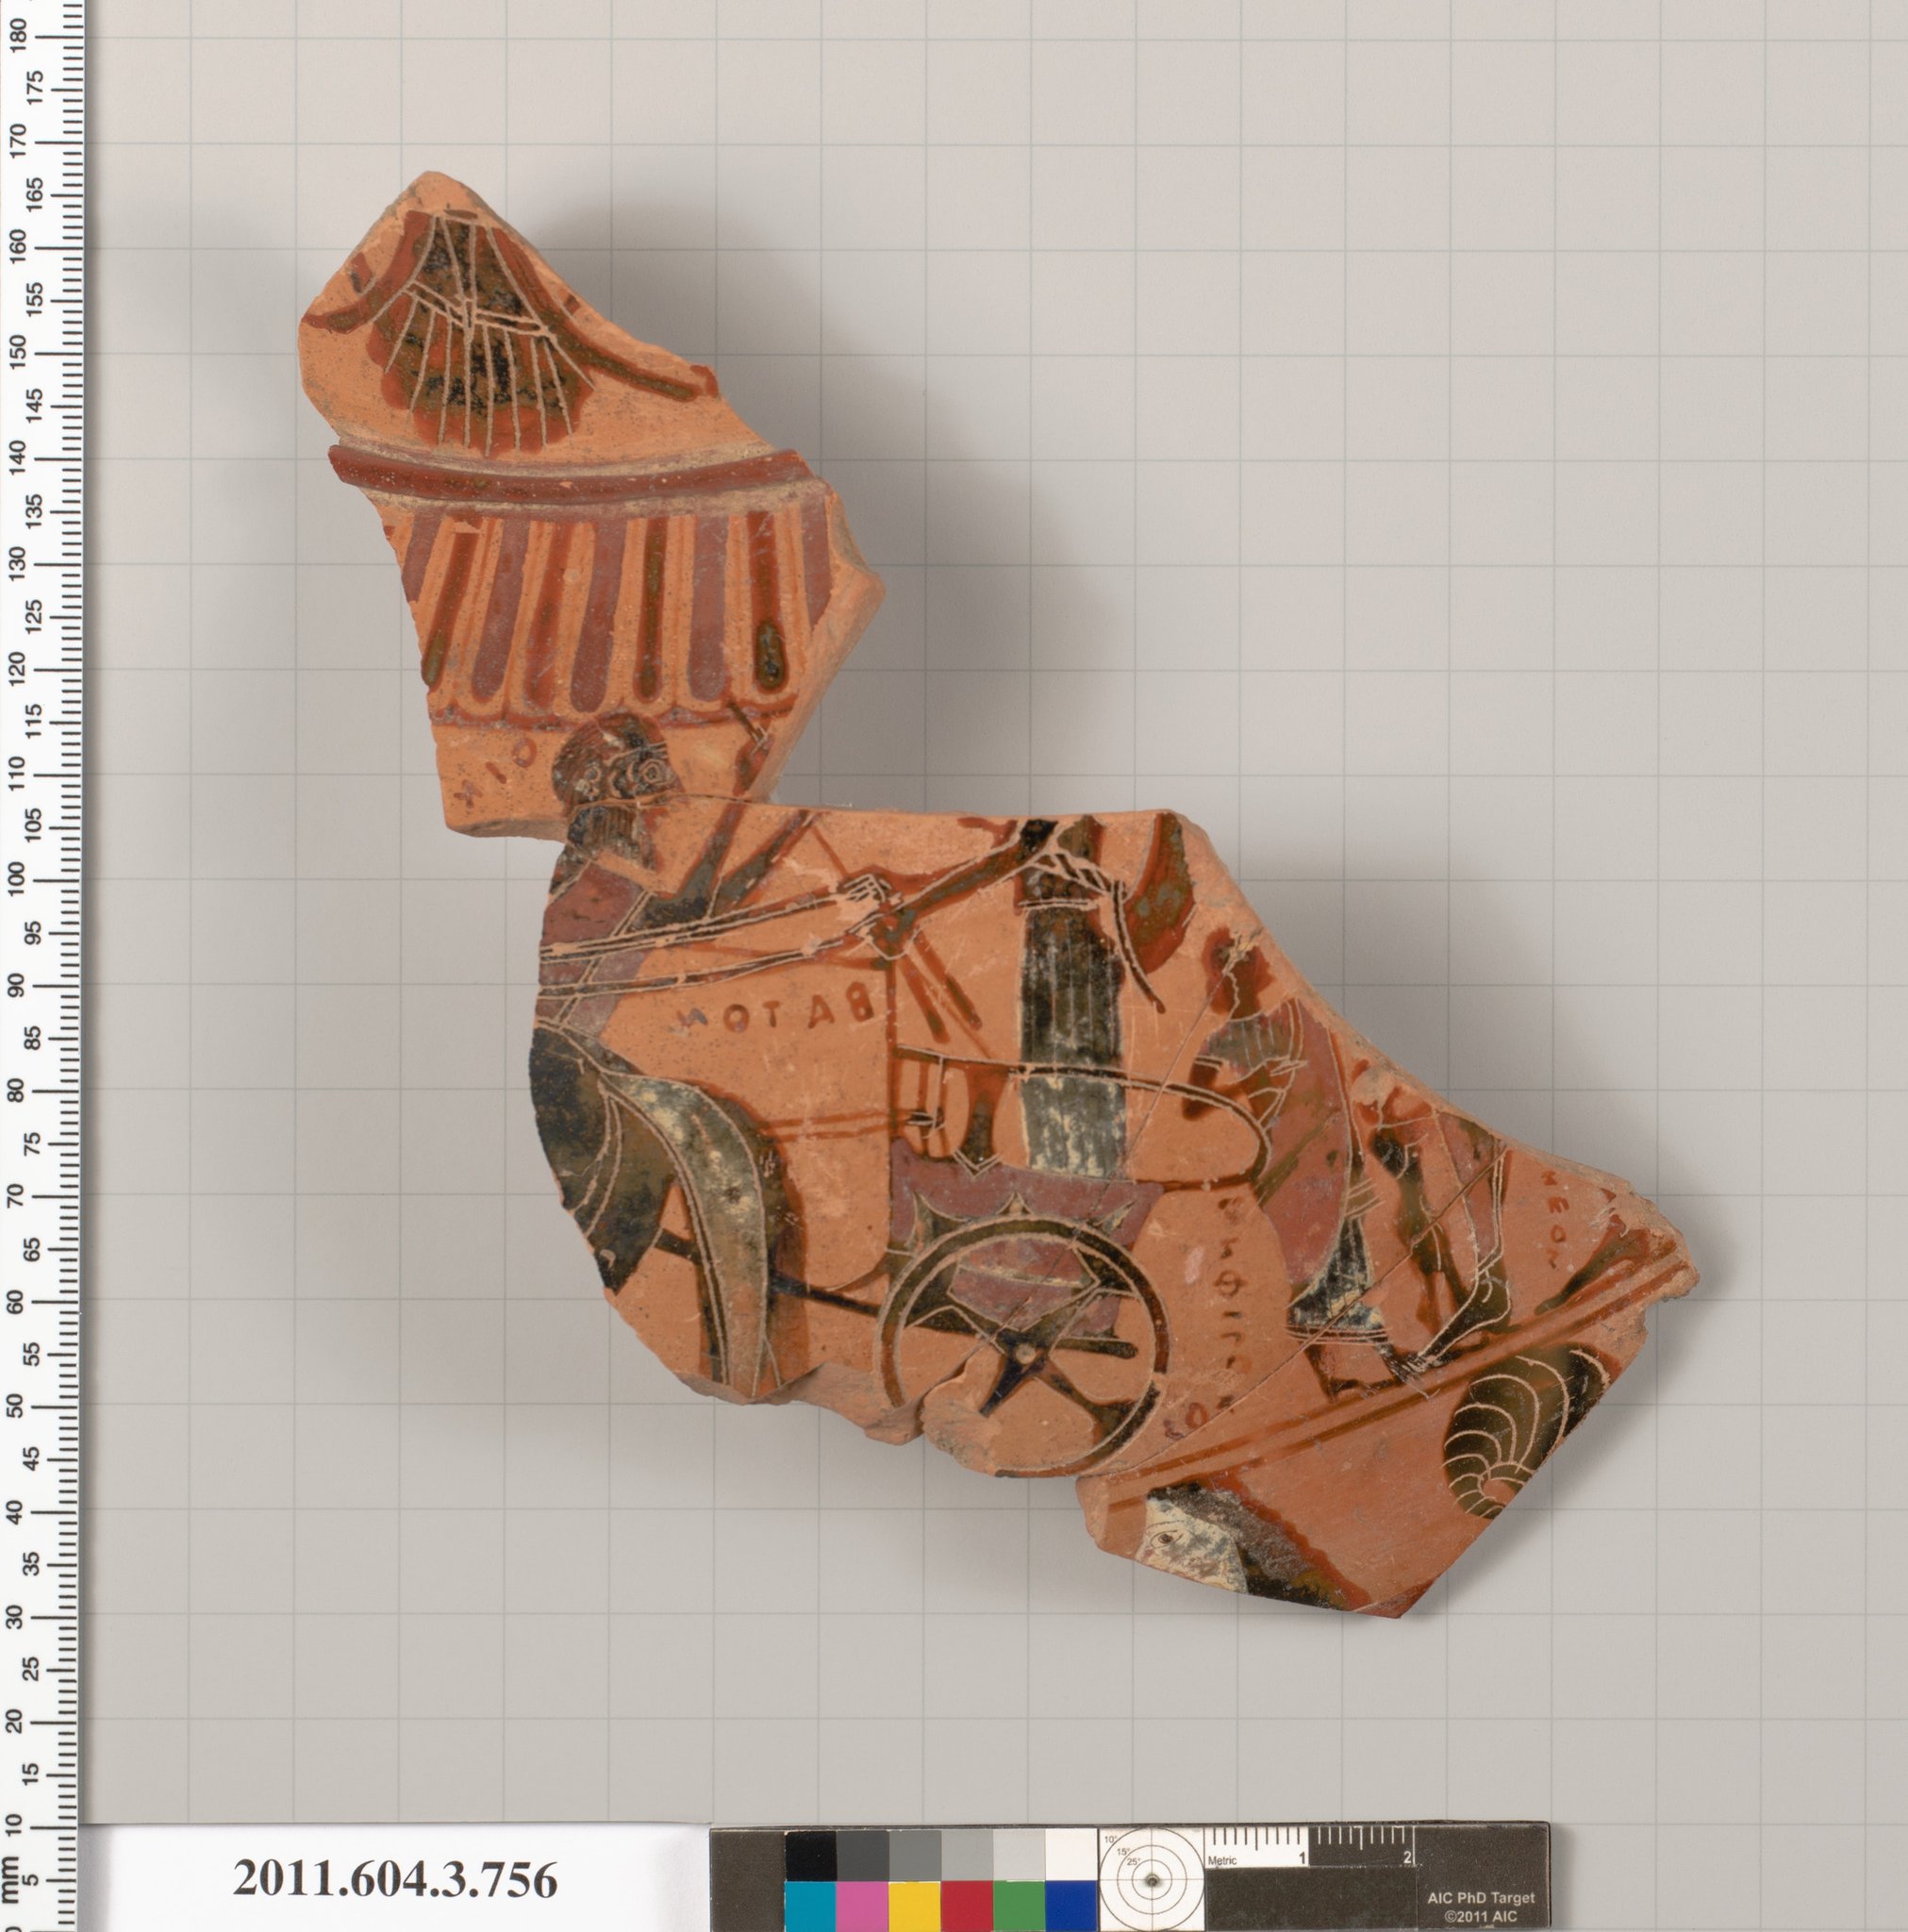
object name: neck amphora, tyrrhenian fragment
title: Terracotta fragment of a neck-amphora (jar)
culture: greek, attic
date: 575-551 BCE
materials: terracotta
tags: chariots